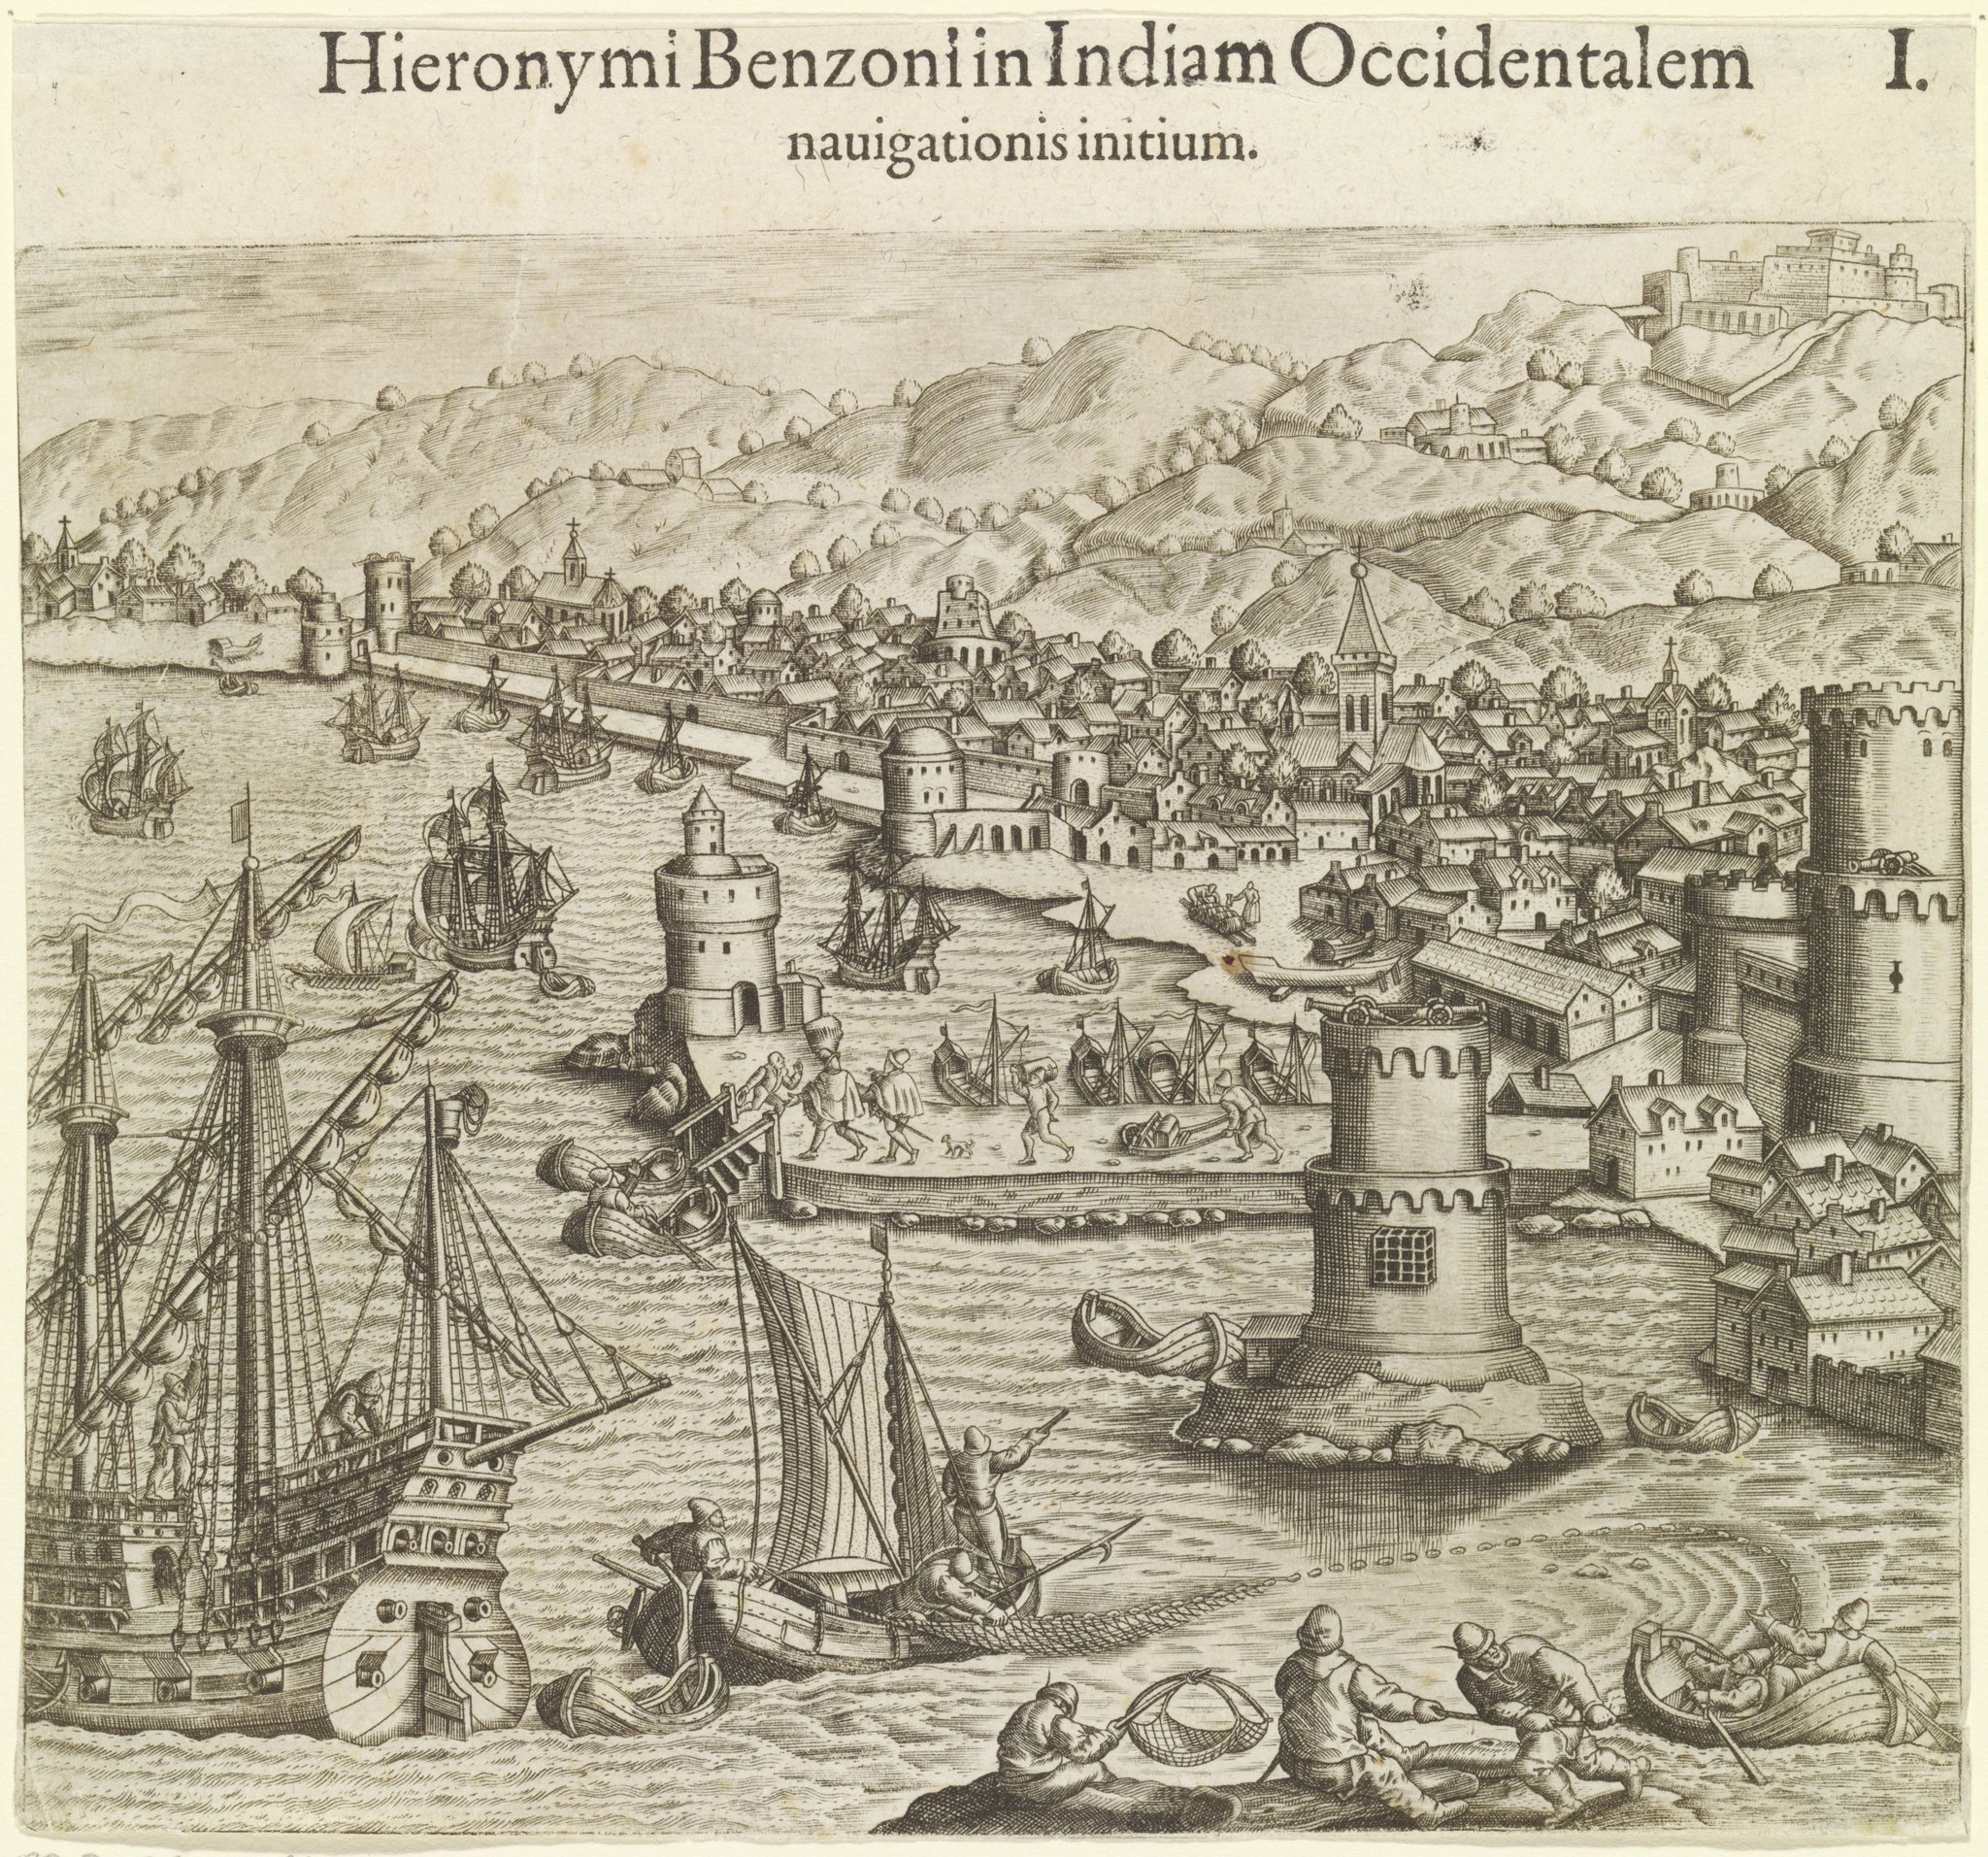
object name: print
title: Hieronymi Benzoni in Indiam Occidentalem nauigationis initium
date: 1594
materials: paper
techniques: engraving, letterpress printing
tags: harbour, adventurer, exploration, expedition, voyage of discovery, spain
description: Afkomstig uit: Collectiones peregrinationum in Indiam occidentalem, dl. 4: Girolamo Benzoni, Americae pars quarta. Sive, Insignis & admiranda historia de reperta primum occidentali India à Christophoro Columbo. Frankfurt am Main: T. de Bry, 1594.